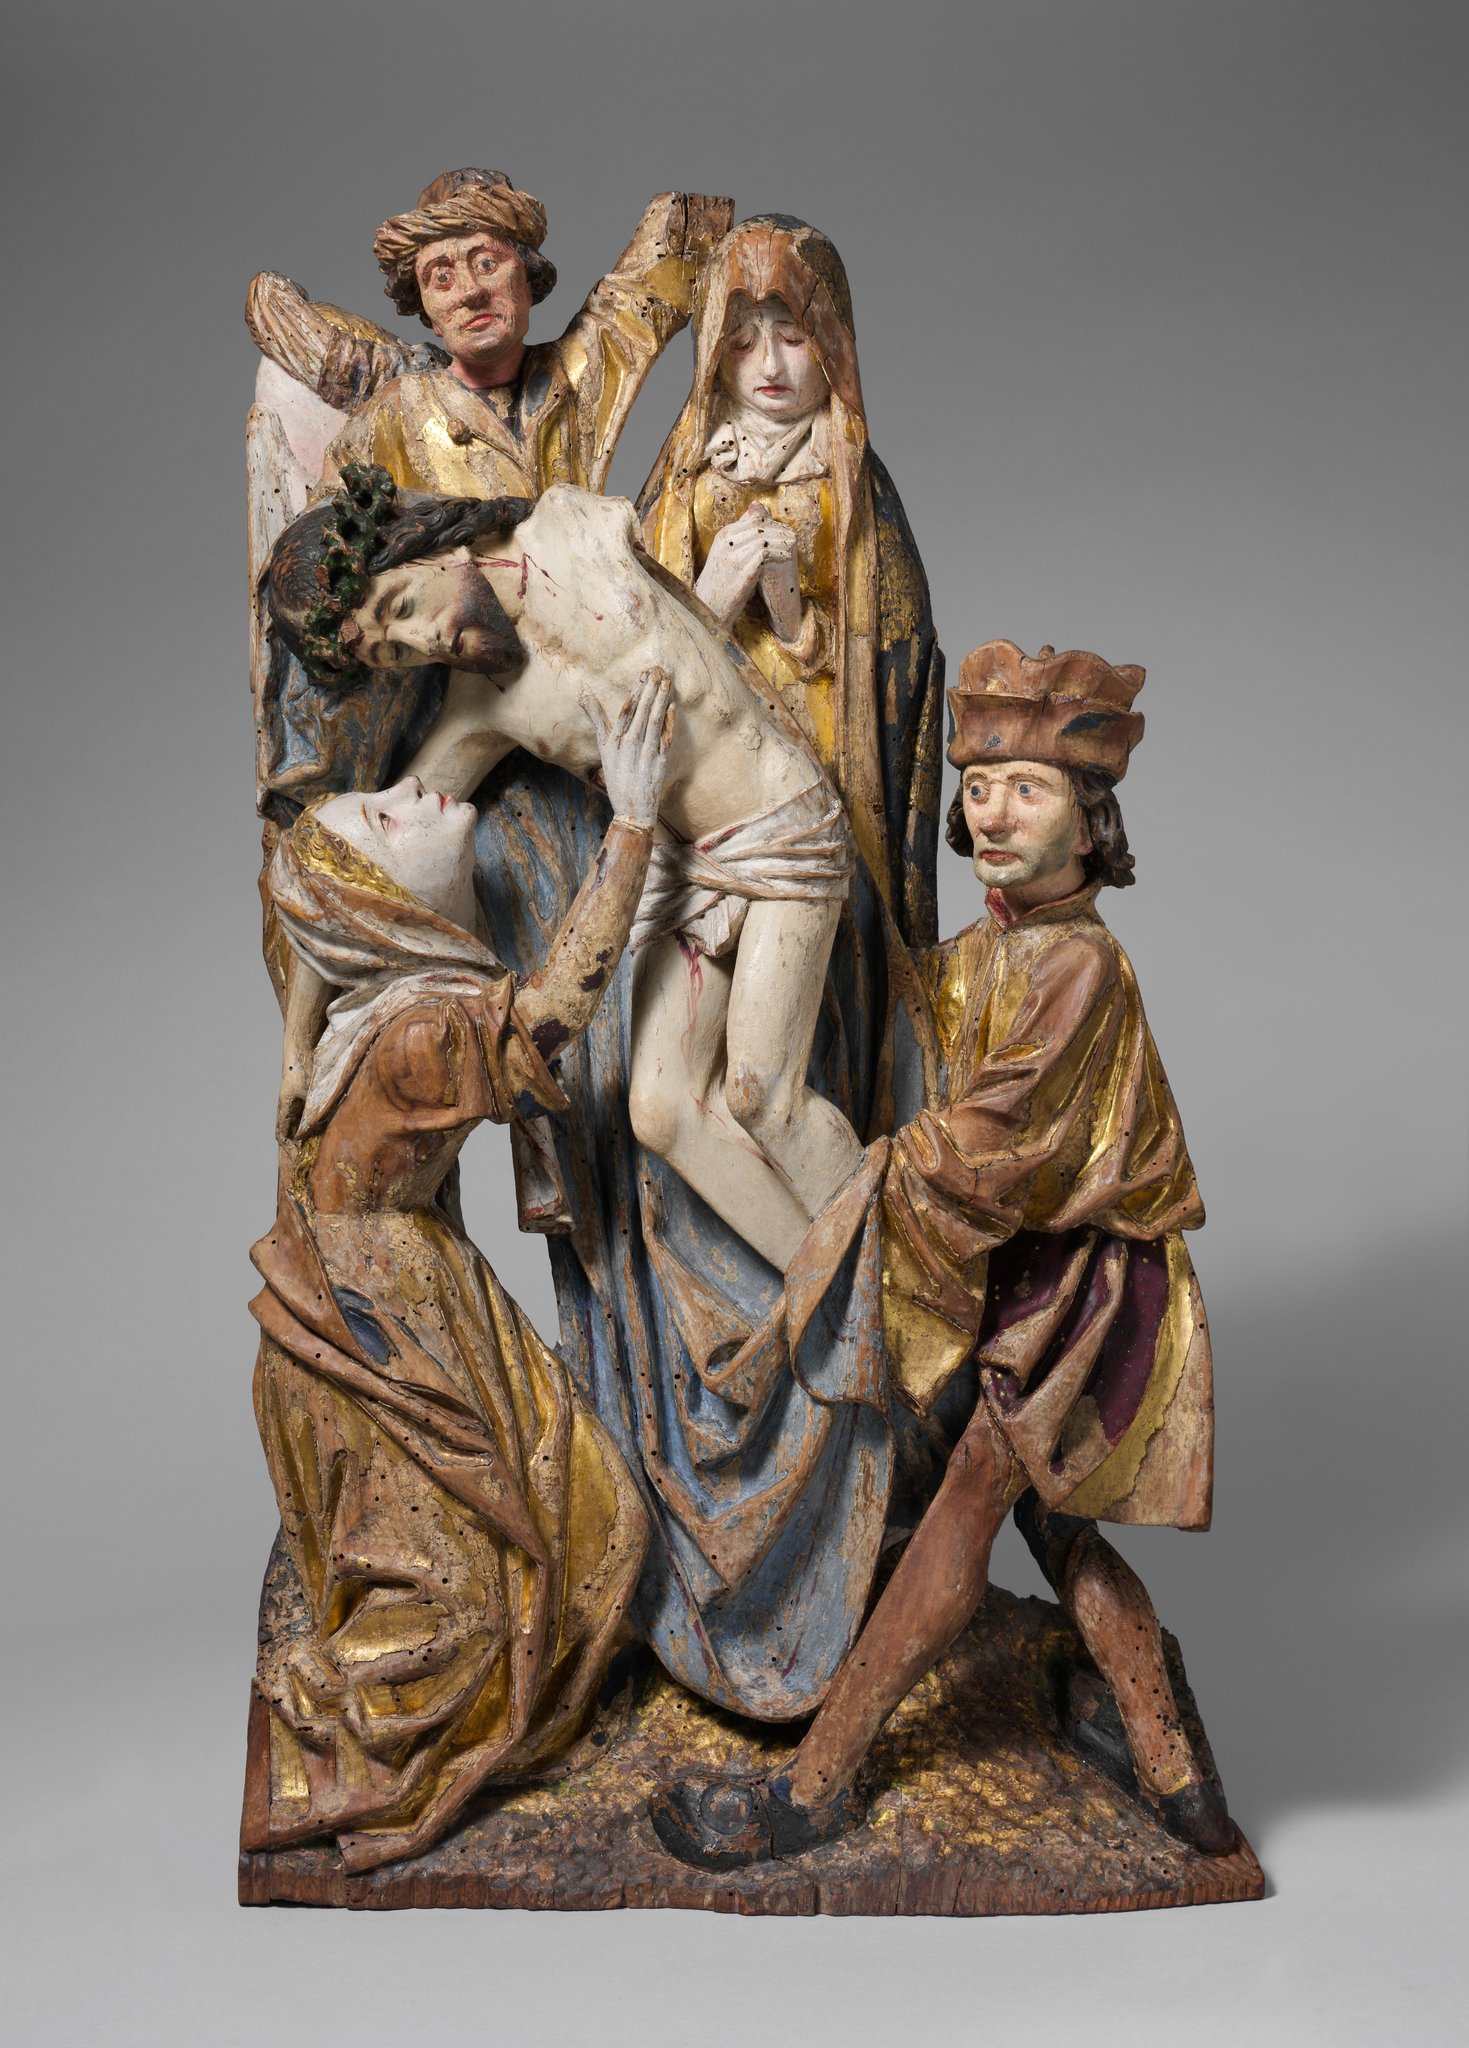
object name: relief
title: Descent from the Cross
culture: south netherlandish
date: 1475-1500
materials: wood, paint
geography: netherlands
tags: christ,mary magdalene,virgin mary,descent from the cross